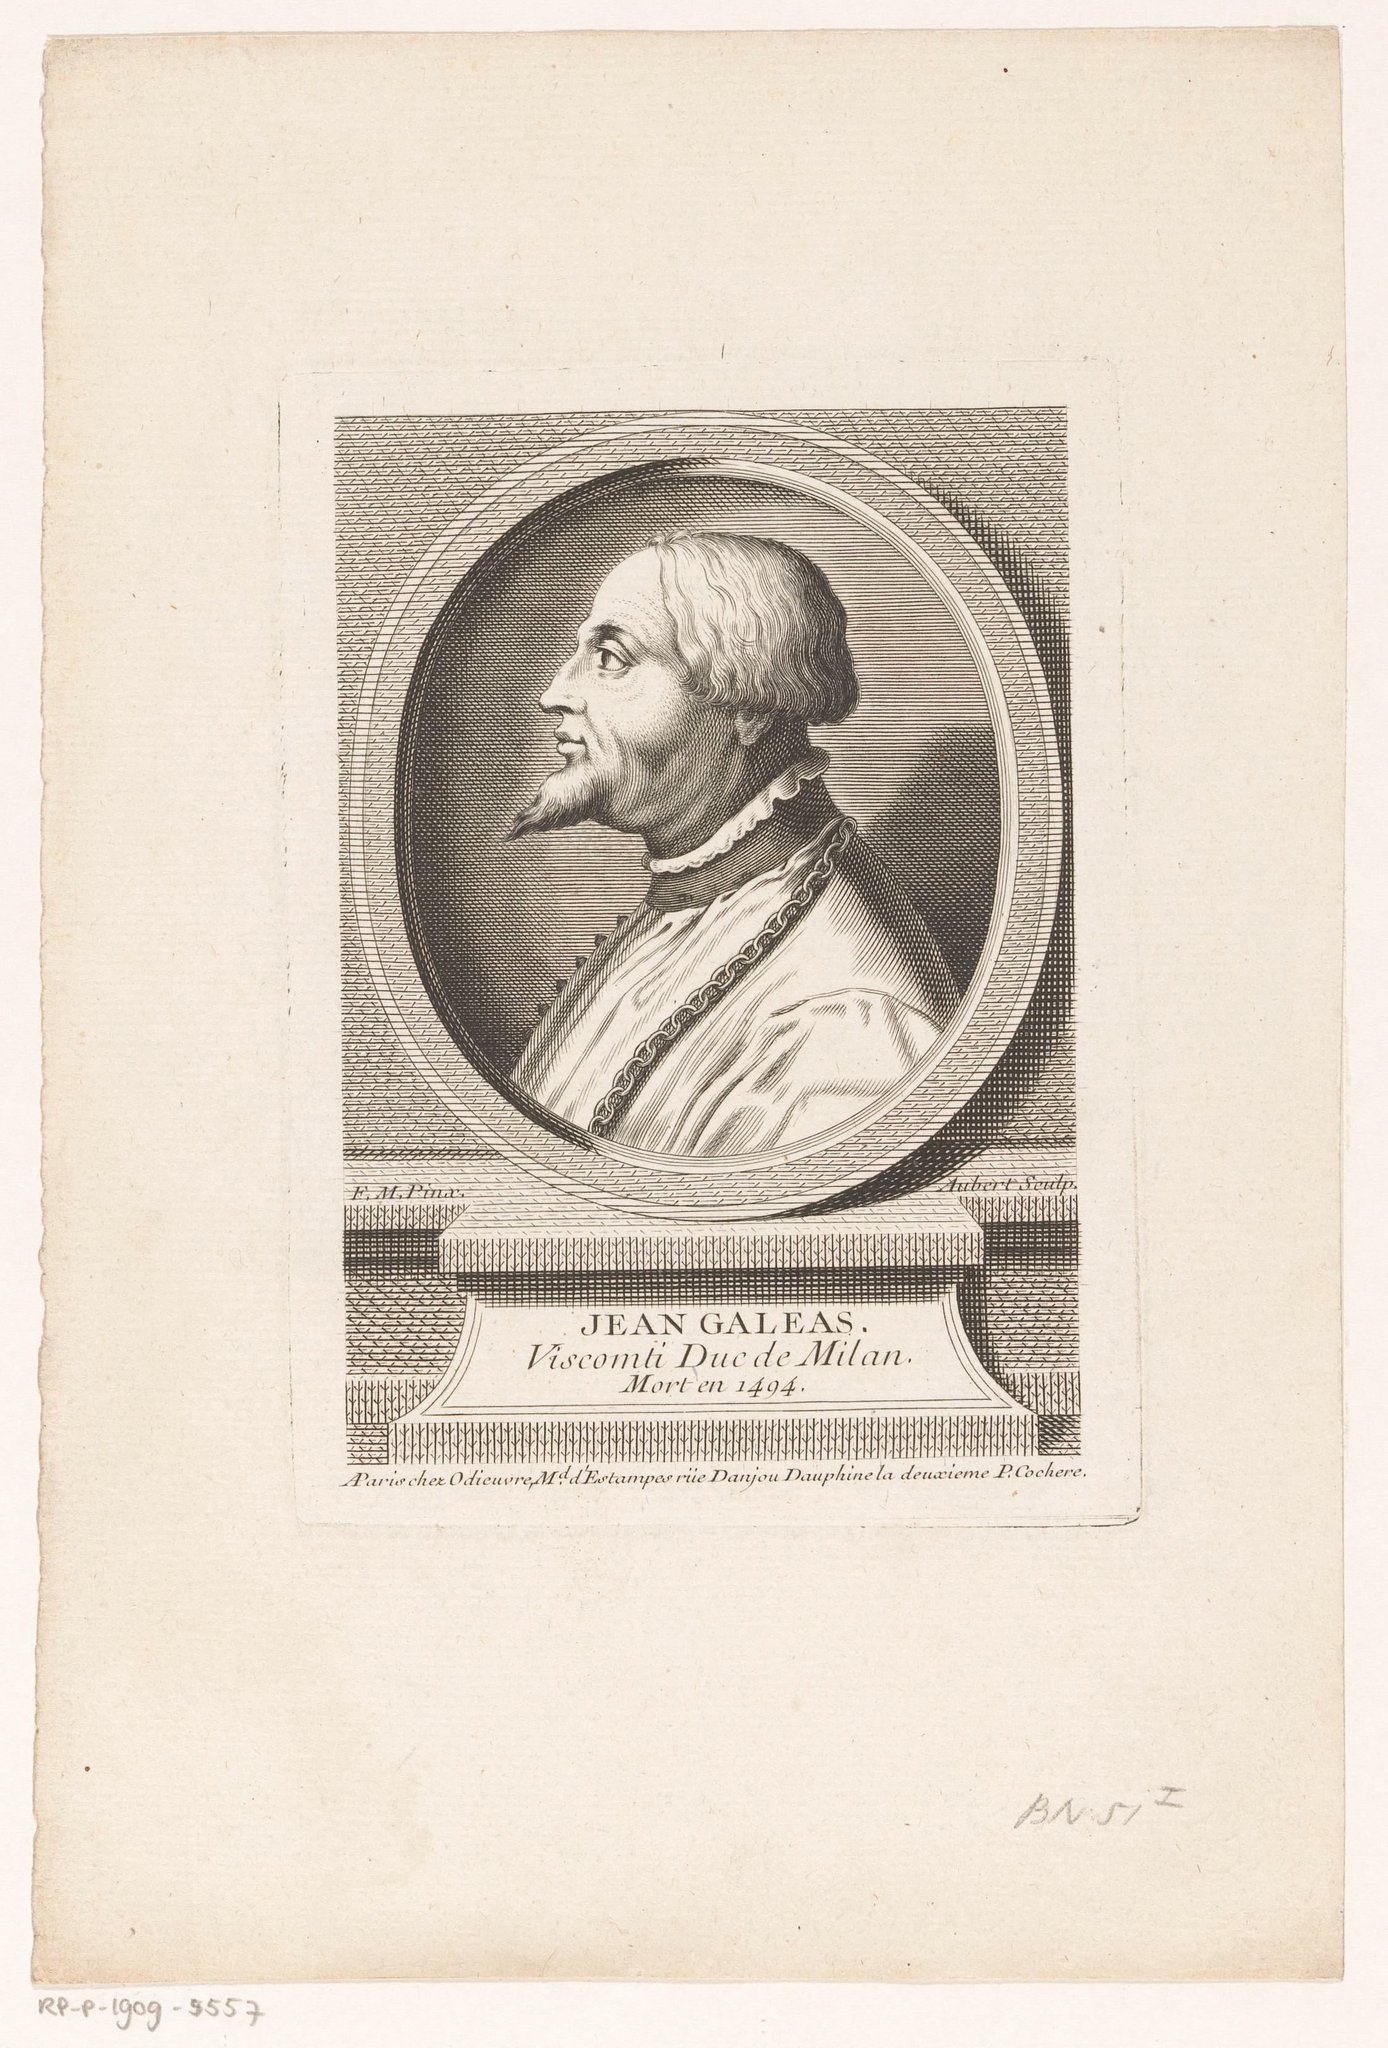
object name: book illustration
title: Portret van Gian Galeazzo Visconti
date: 1755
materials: paper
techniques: engraving, etching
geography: paris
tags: historical persons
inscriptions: collector's mark: Lugt 2228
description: Prent uit M. Dreux du Radier. L'Europe illustre, contenant l'histoire abregée (...). Parijs: M. Oudrieuve, A.-F. Le Breton, 1755.